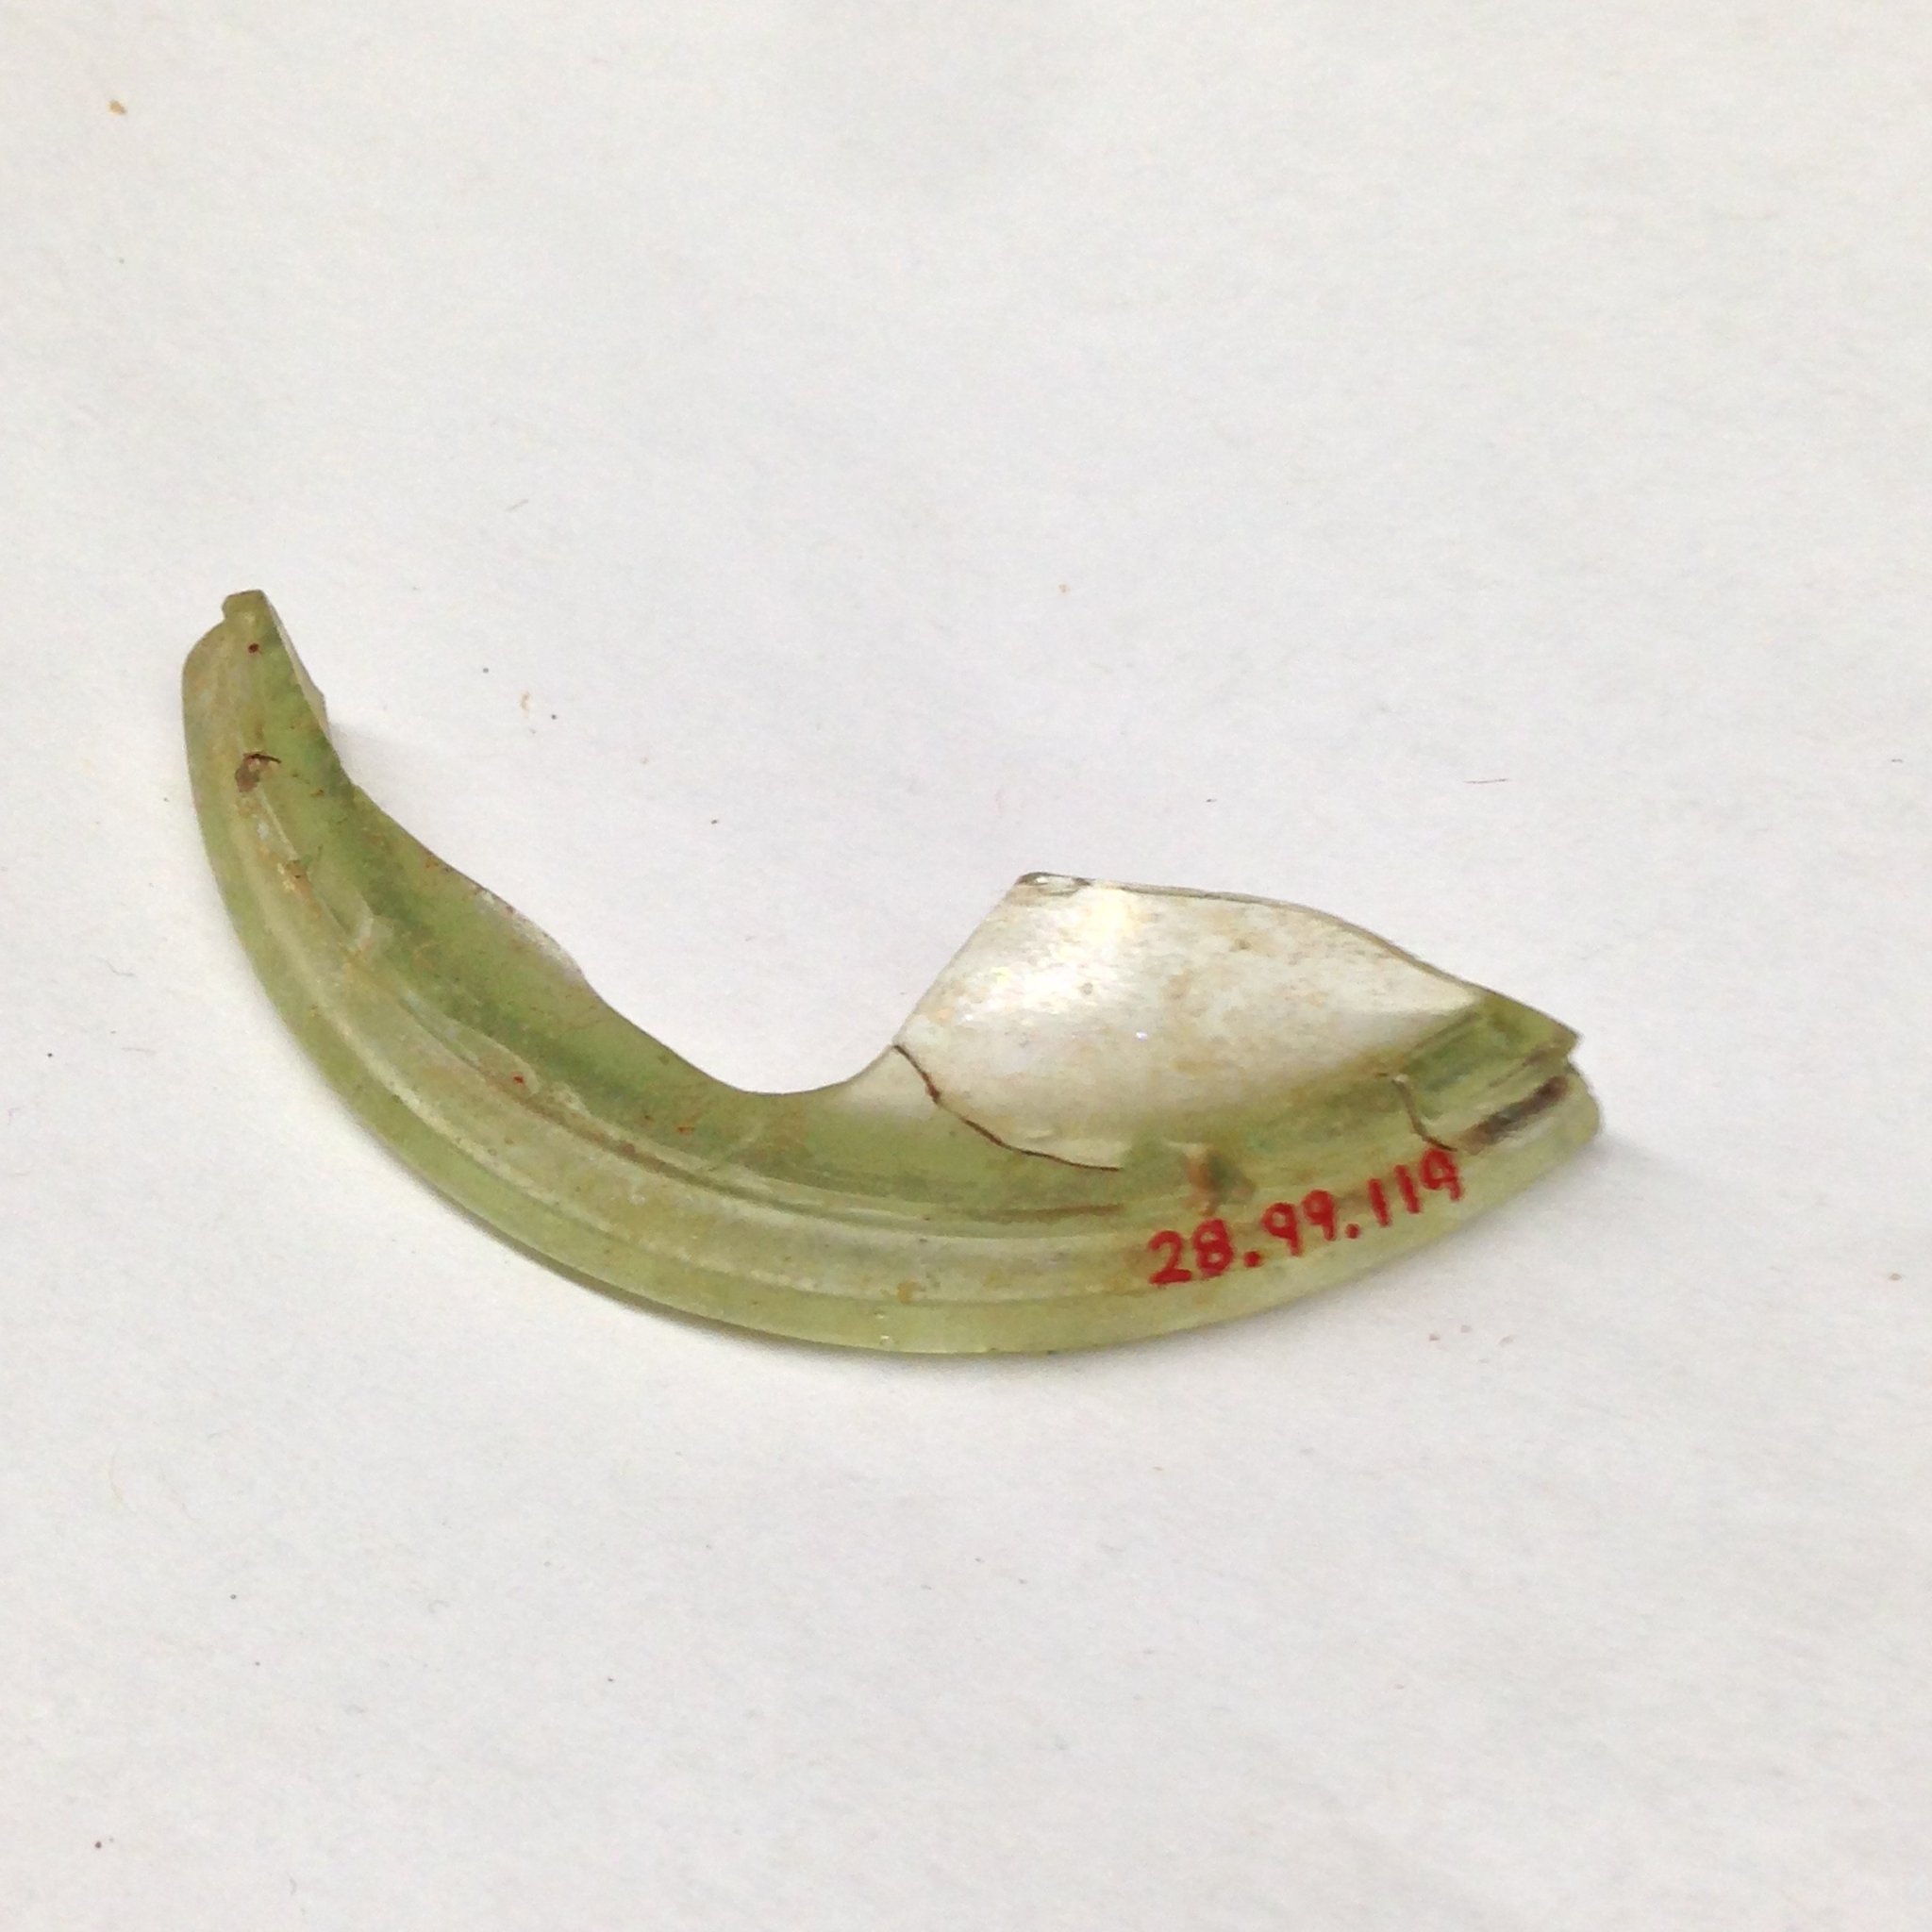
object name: fragment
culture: european or middle eastern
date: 1150-1250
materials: ceramic, glass